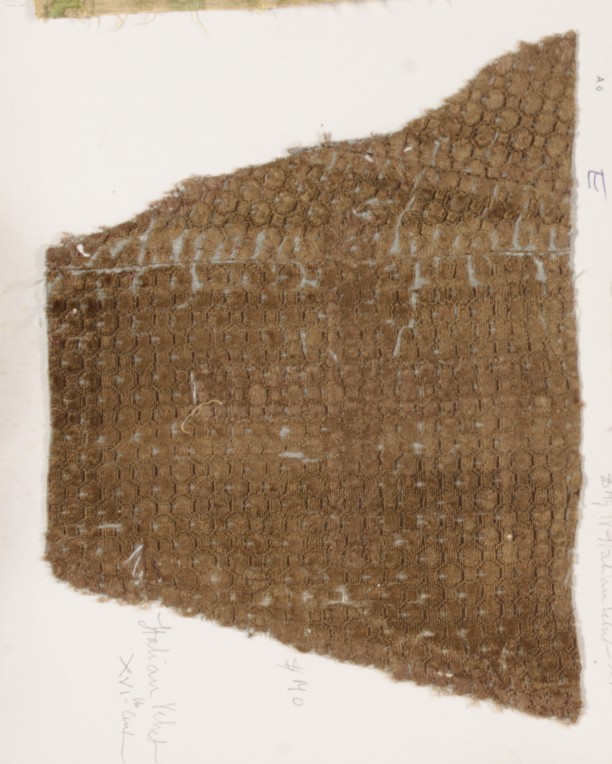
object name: fragment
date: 1501-1600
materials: silk